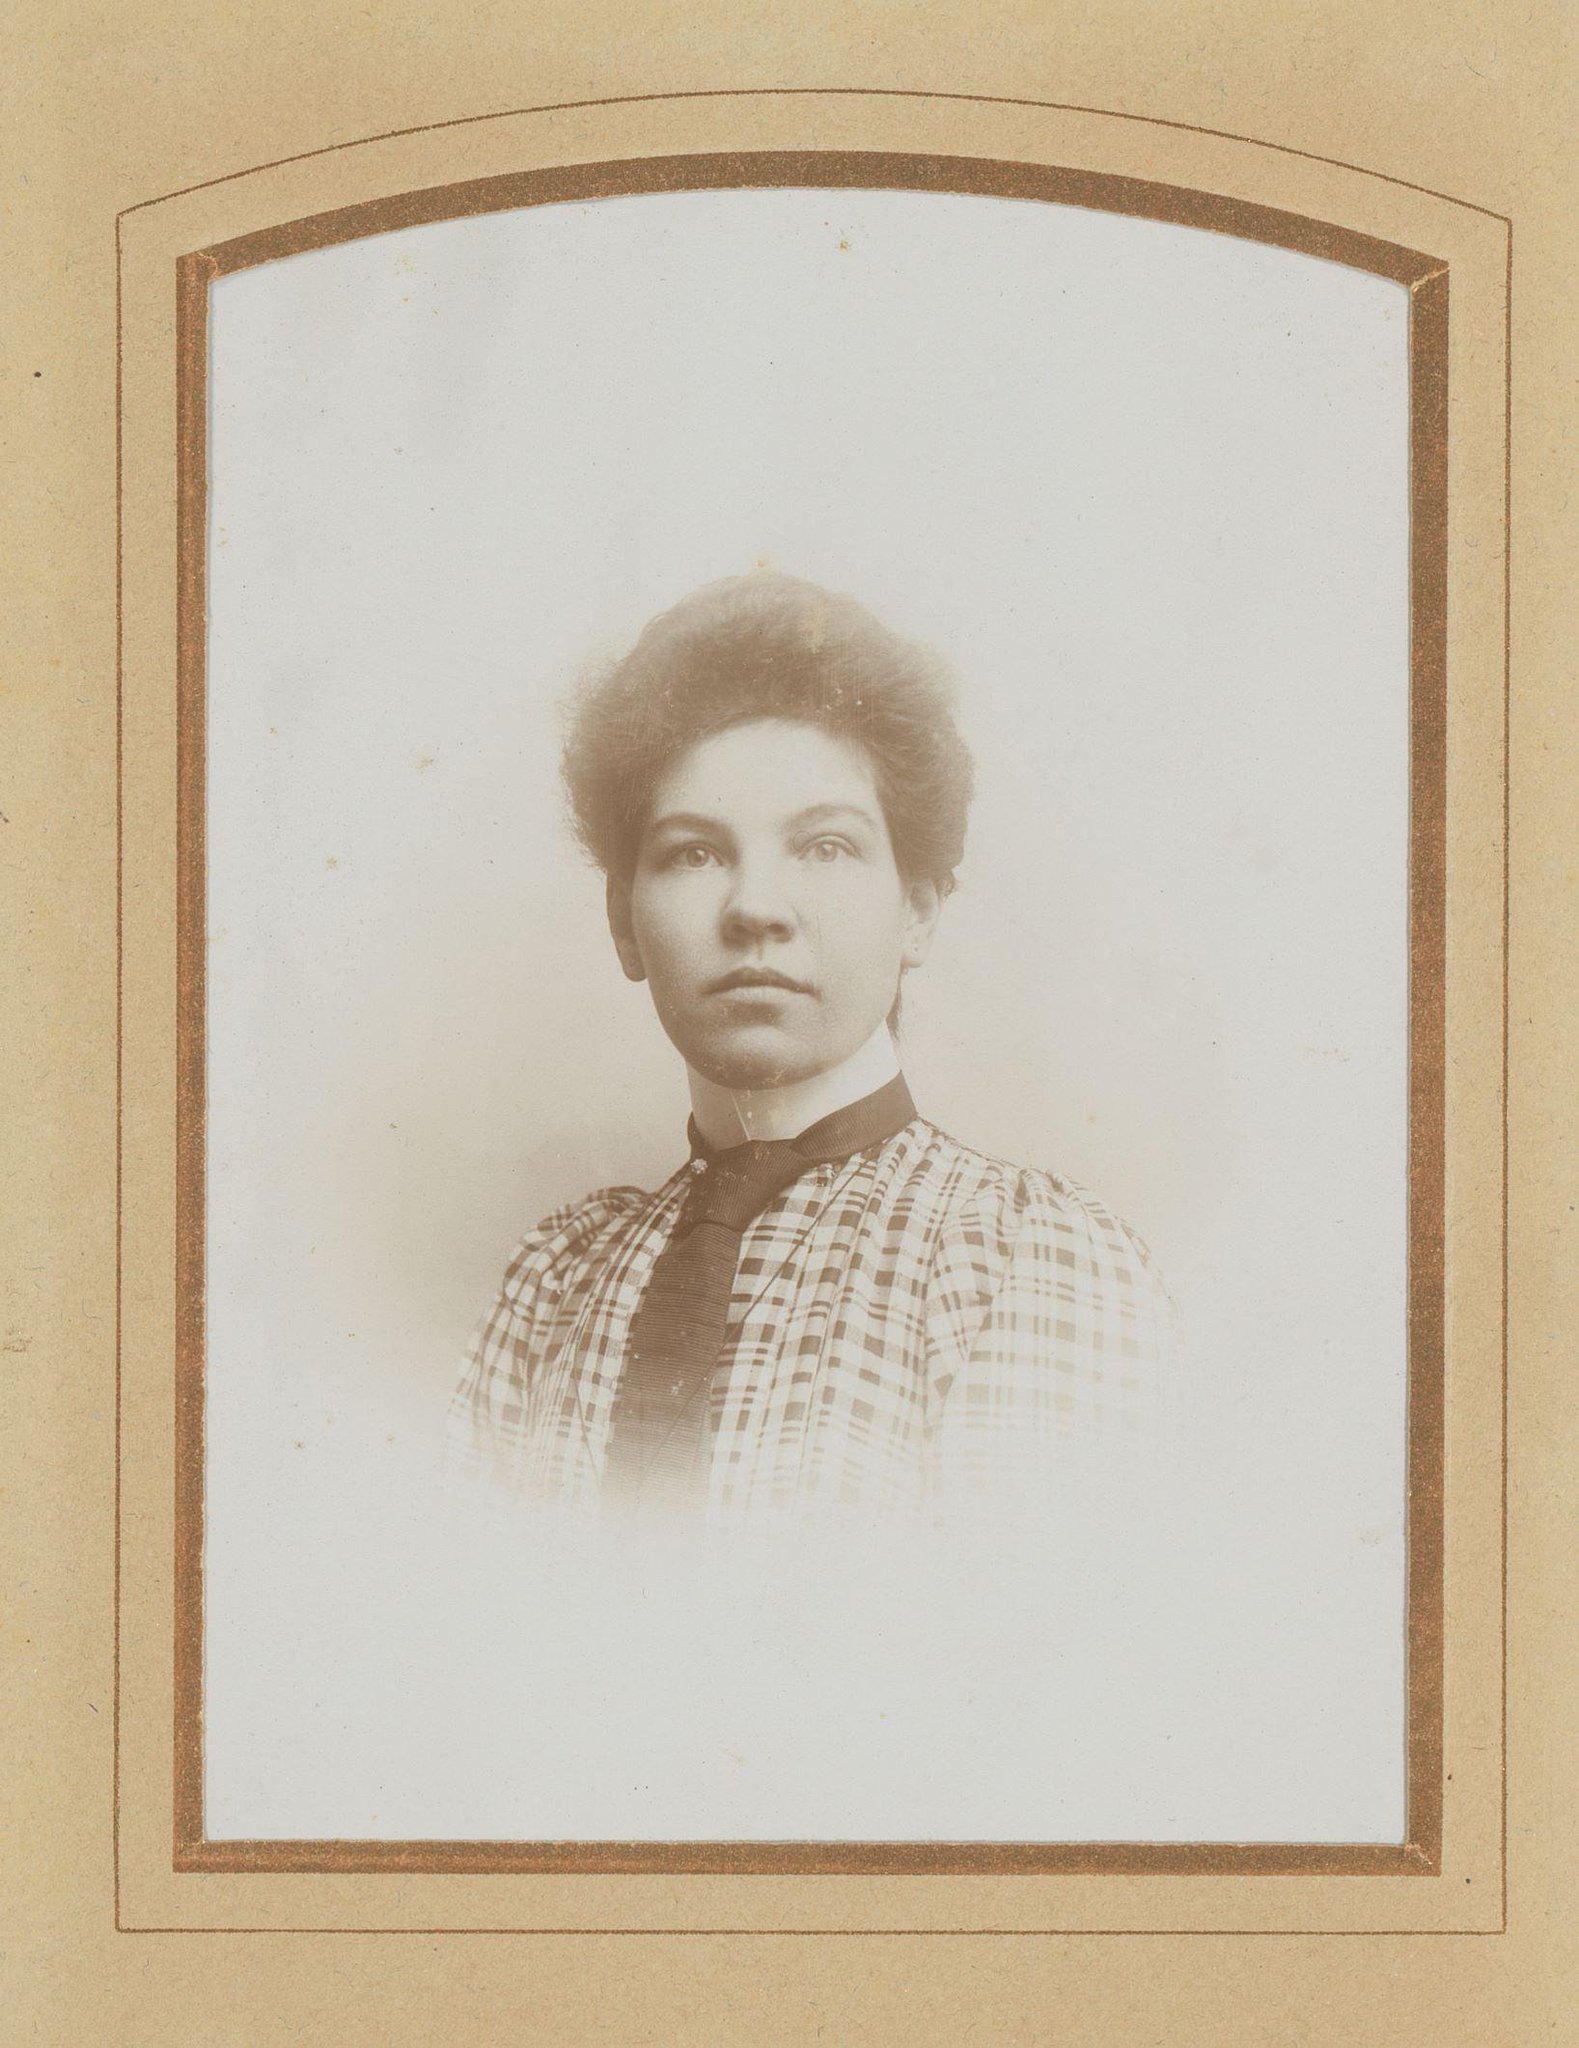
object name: album leaf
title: Portret van een vrouw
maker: cornelis bethlehem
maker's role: fotograaf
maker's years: 1873-1918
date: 1894-1913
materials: cardboard, photographic support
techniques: collodion silver print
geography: den helder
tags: historical persons - bb - woman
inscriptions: inscription: ‘C. Bethlehem Jzn/ Weststraat No 14/ Helder’